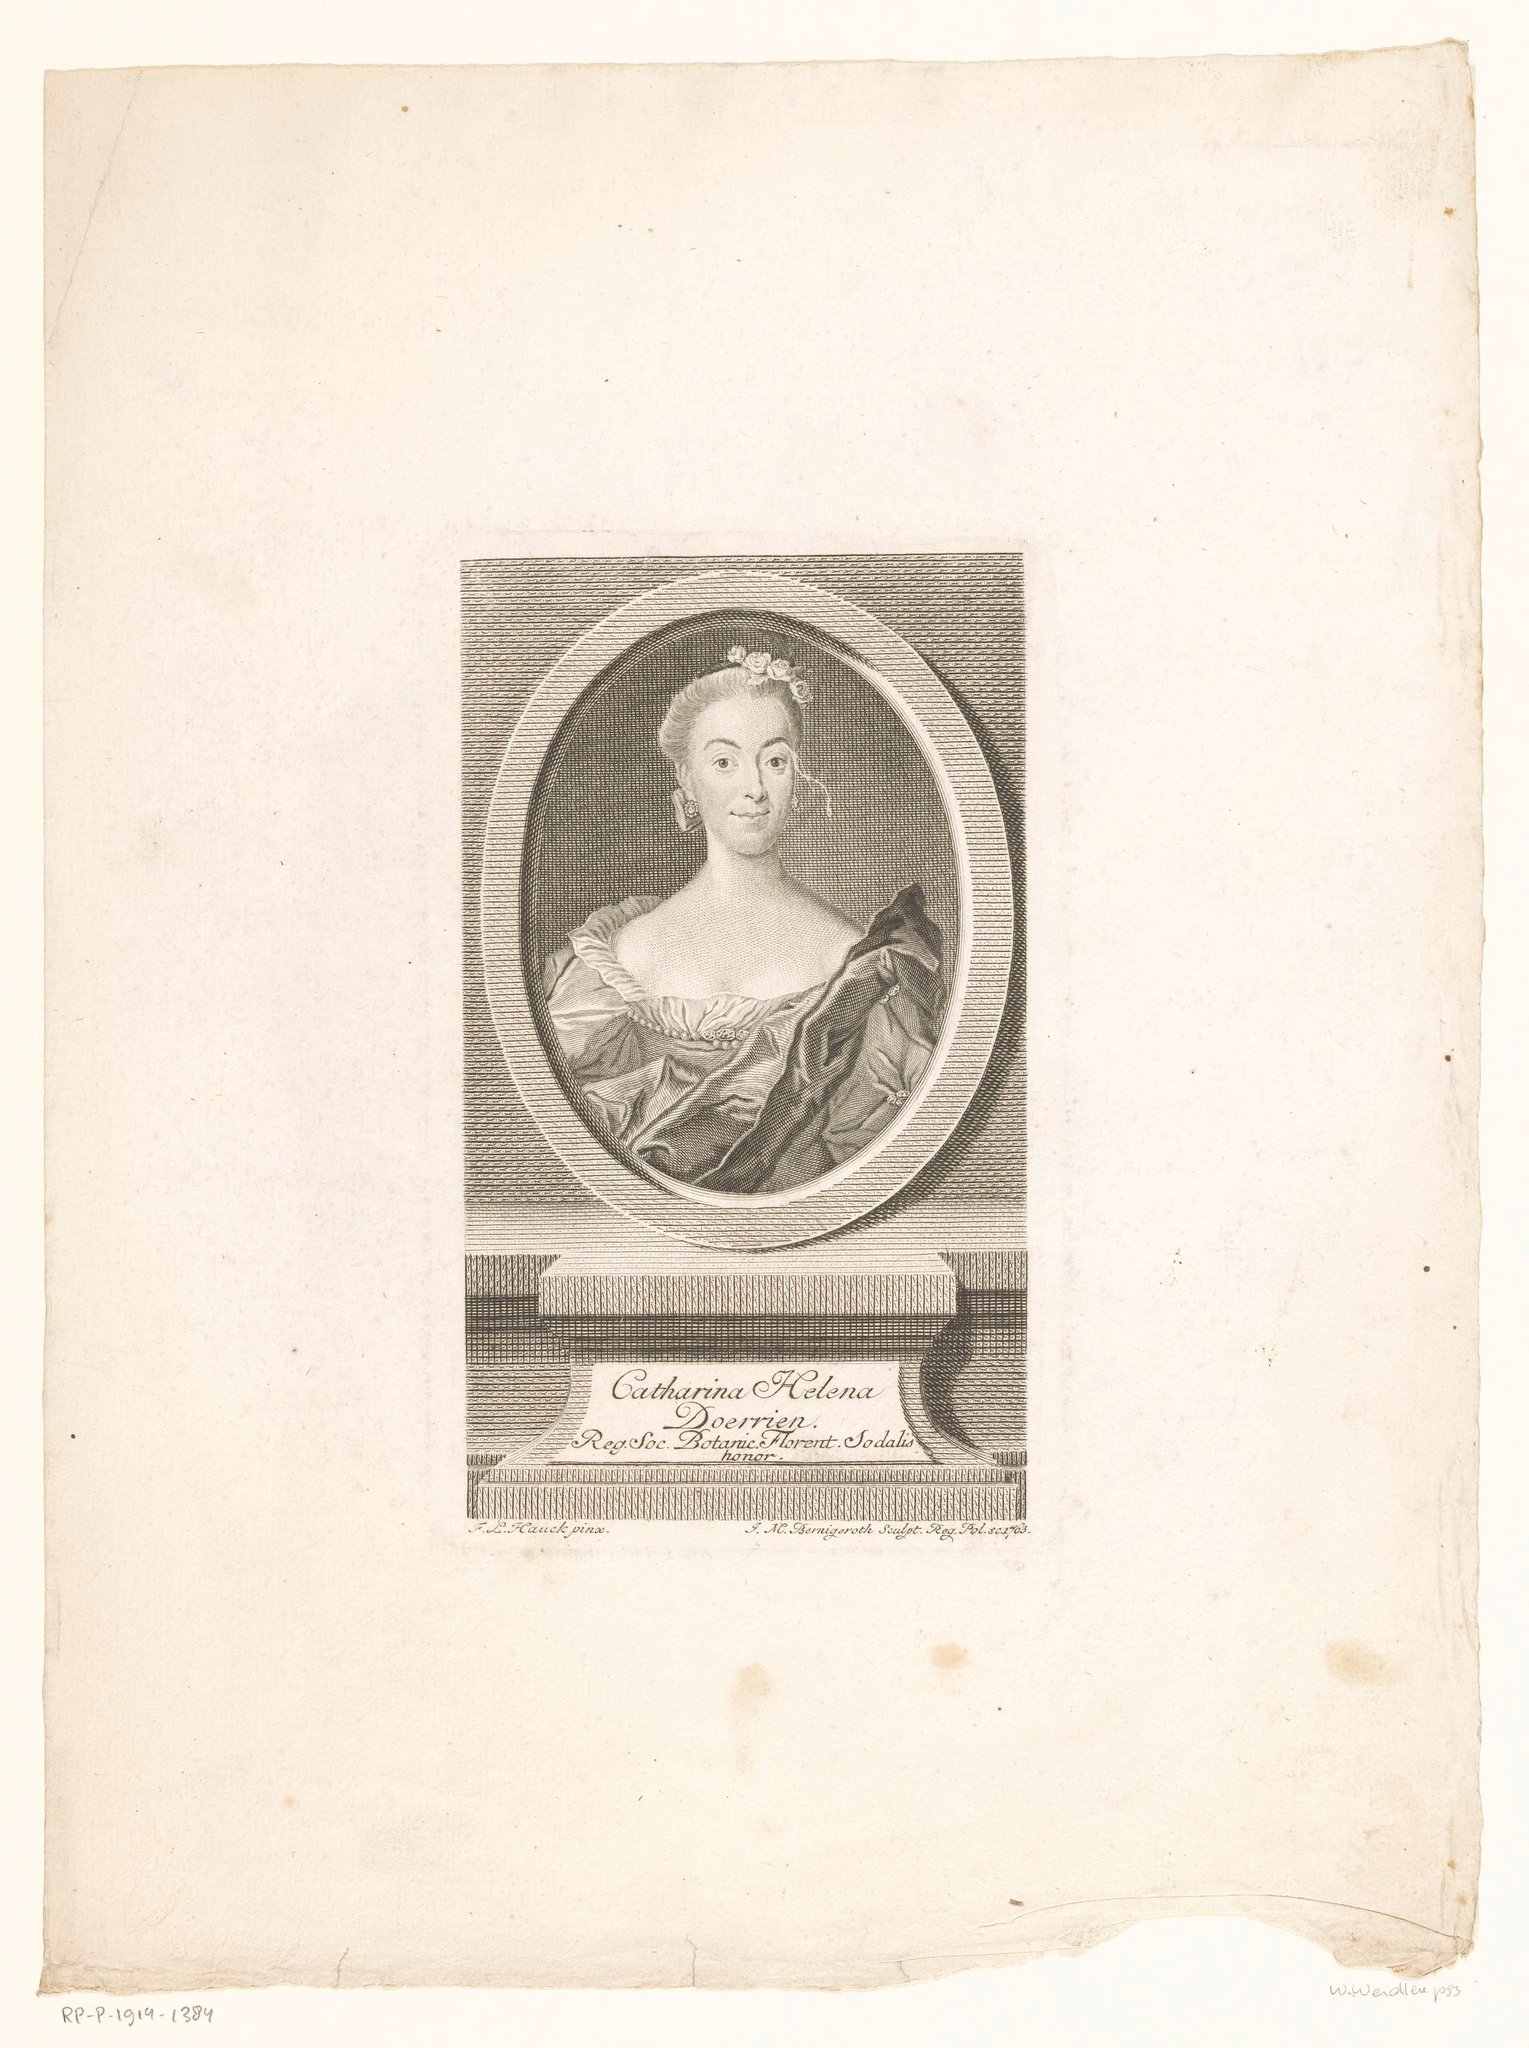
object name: print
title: Portret van Catharina Helena Doerrien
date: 1763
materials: paper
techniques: engraving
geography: leipzig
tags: historical persons - bb - woman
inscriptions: collector's mark: Lugt 2228